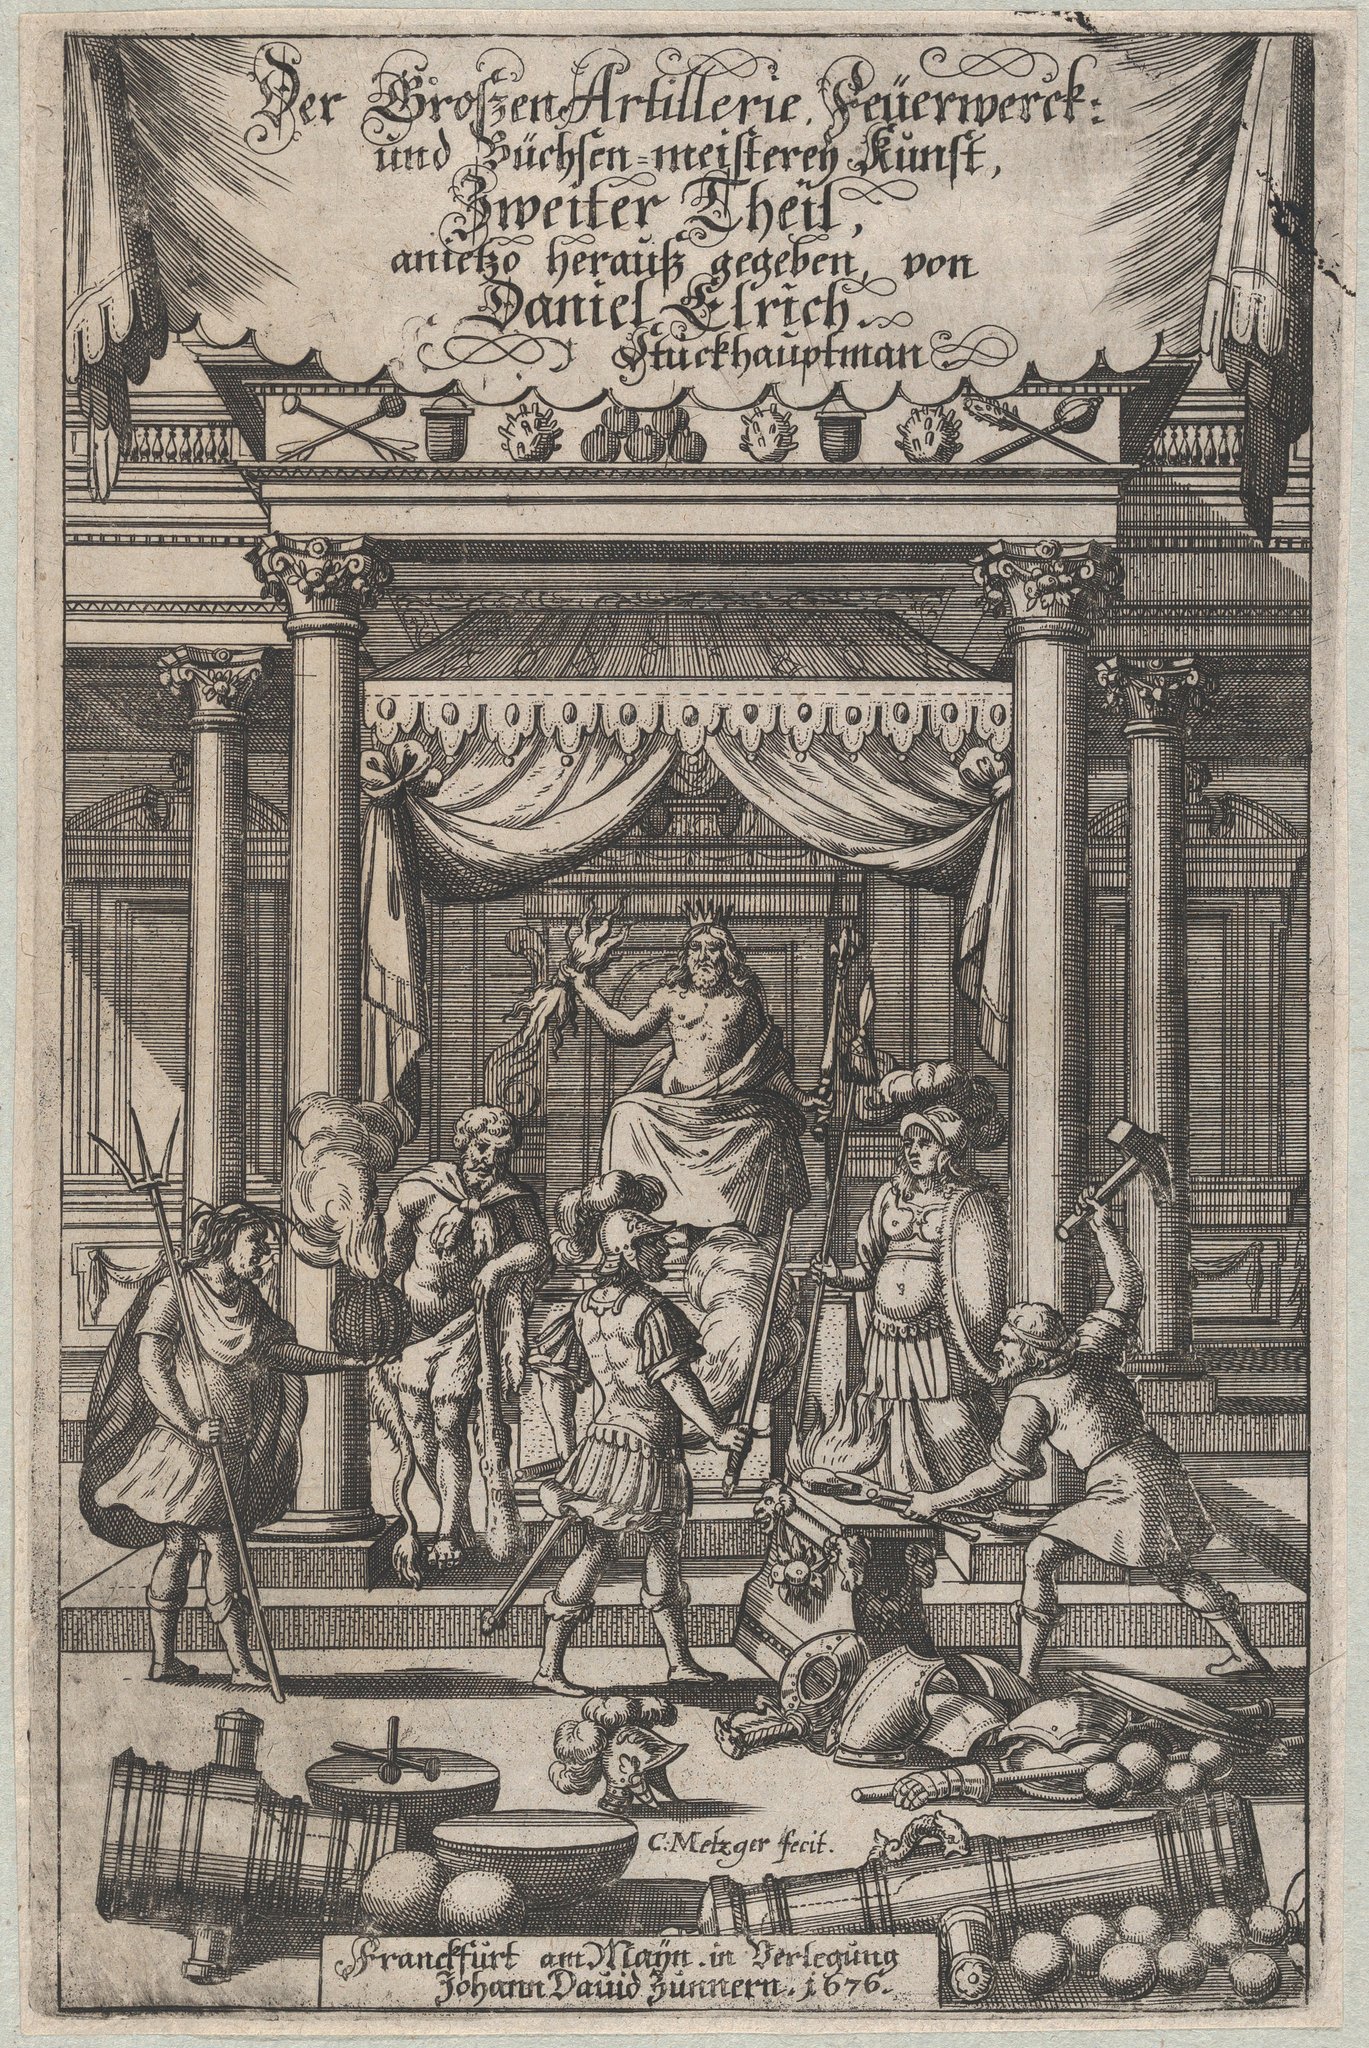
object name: print, fete, ornament architecture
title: Title page, 'Der Grossen Artillerie Feuerwerck ...'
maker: christoph metzger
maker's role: artist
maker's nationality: german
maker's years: 1600-1682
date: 1676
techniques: etching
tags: soldiers,shields,spears,men,hammers